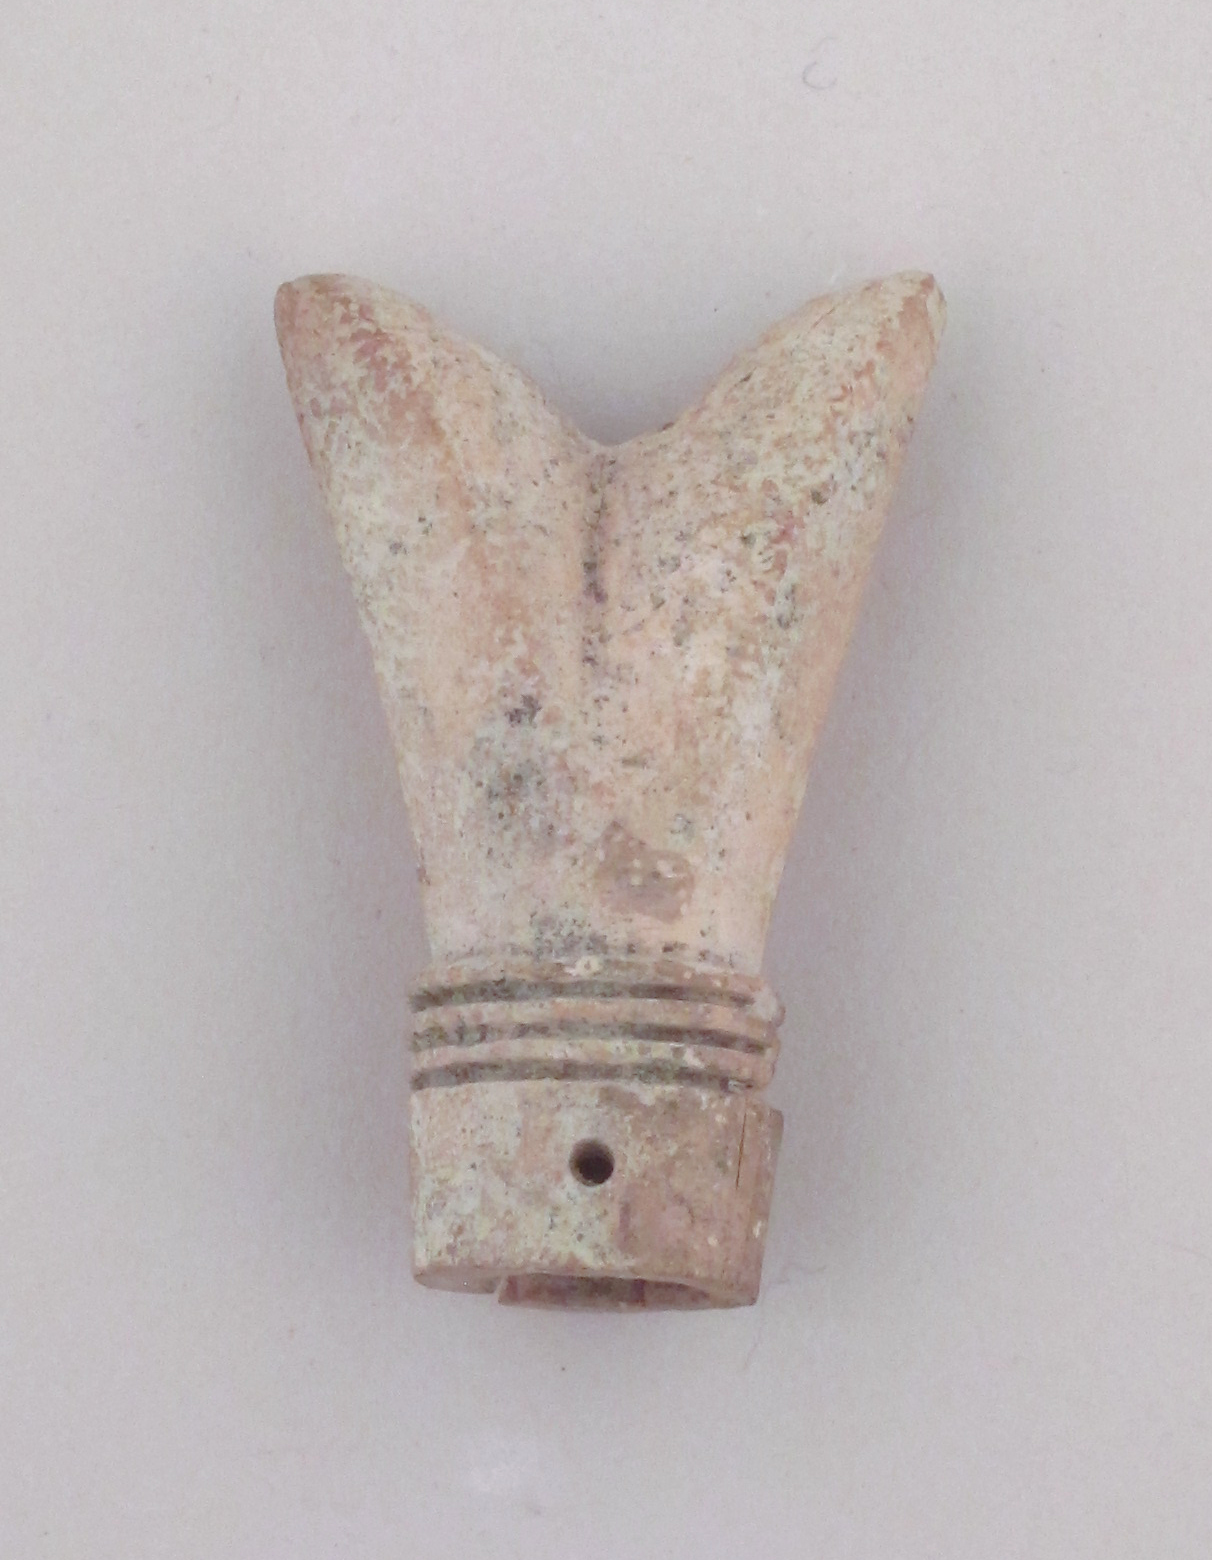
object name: finial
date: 7000 BCE-330 CE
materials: ivory